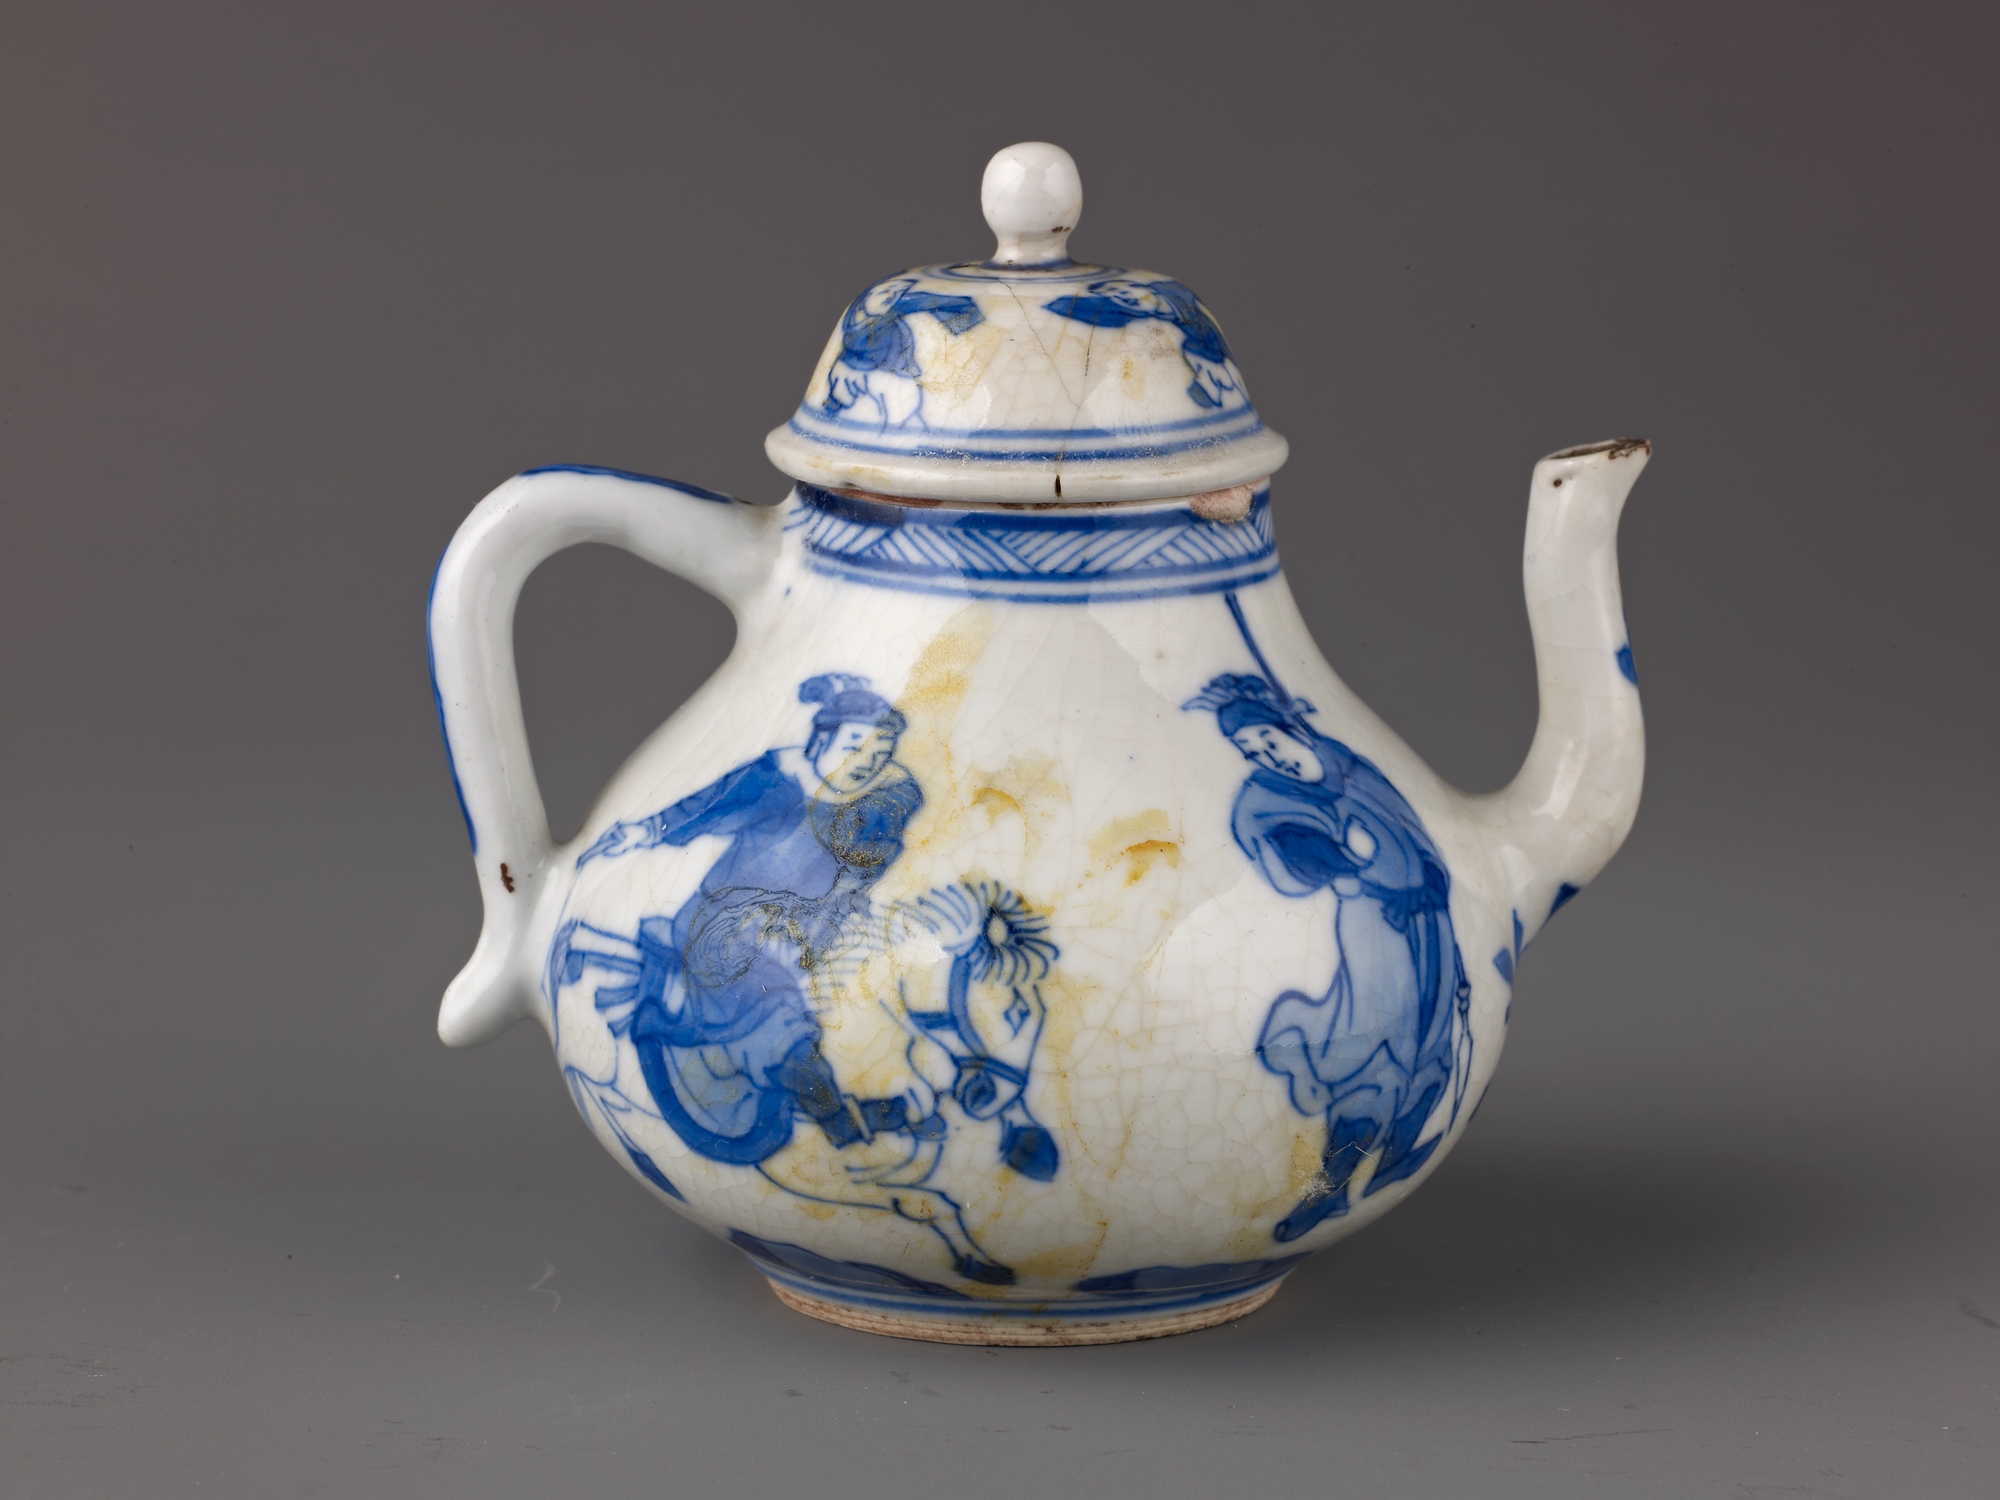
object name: covered winepot or teapot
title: Small covered wine pot or teapot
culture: chinese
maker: chinese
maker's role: artist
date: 1662-1722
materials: porcelain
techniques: painting, underglaze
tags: boys,men,horses